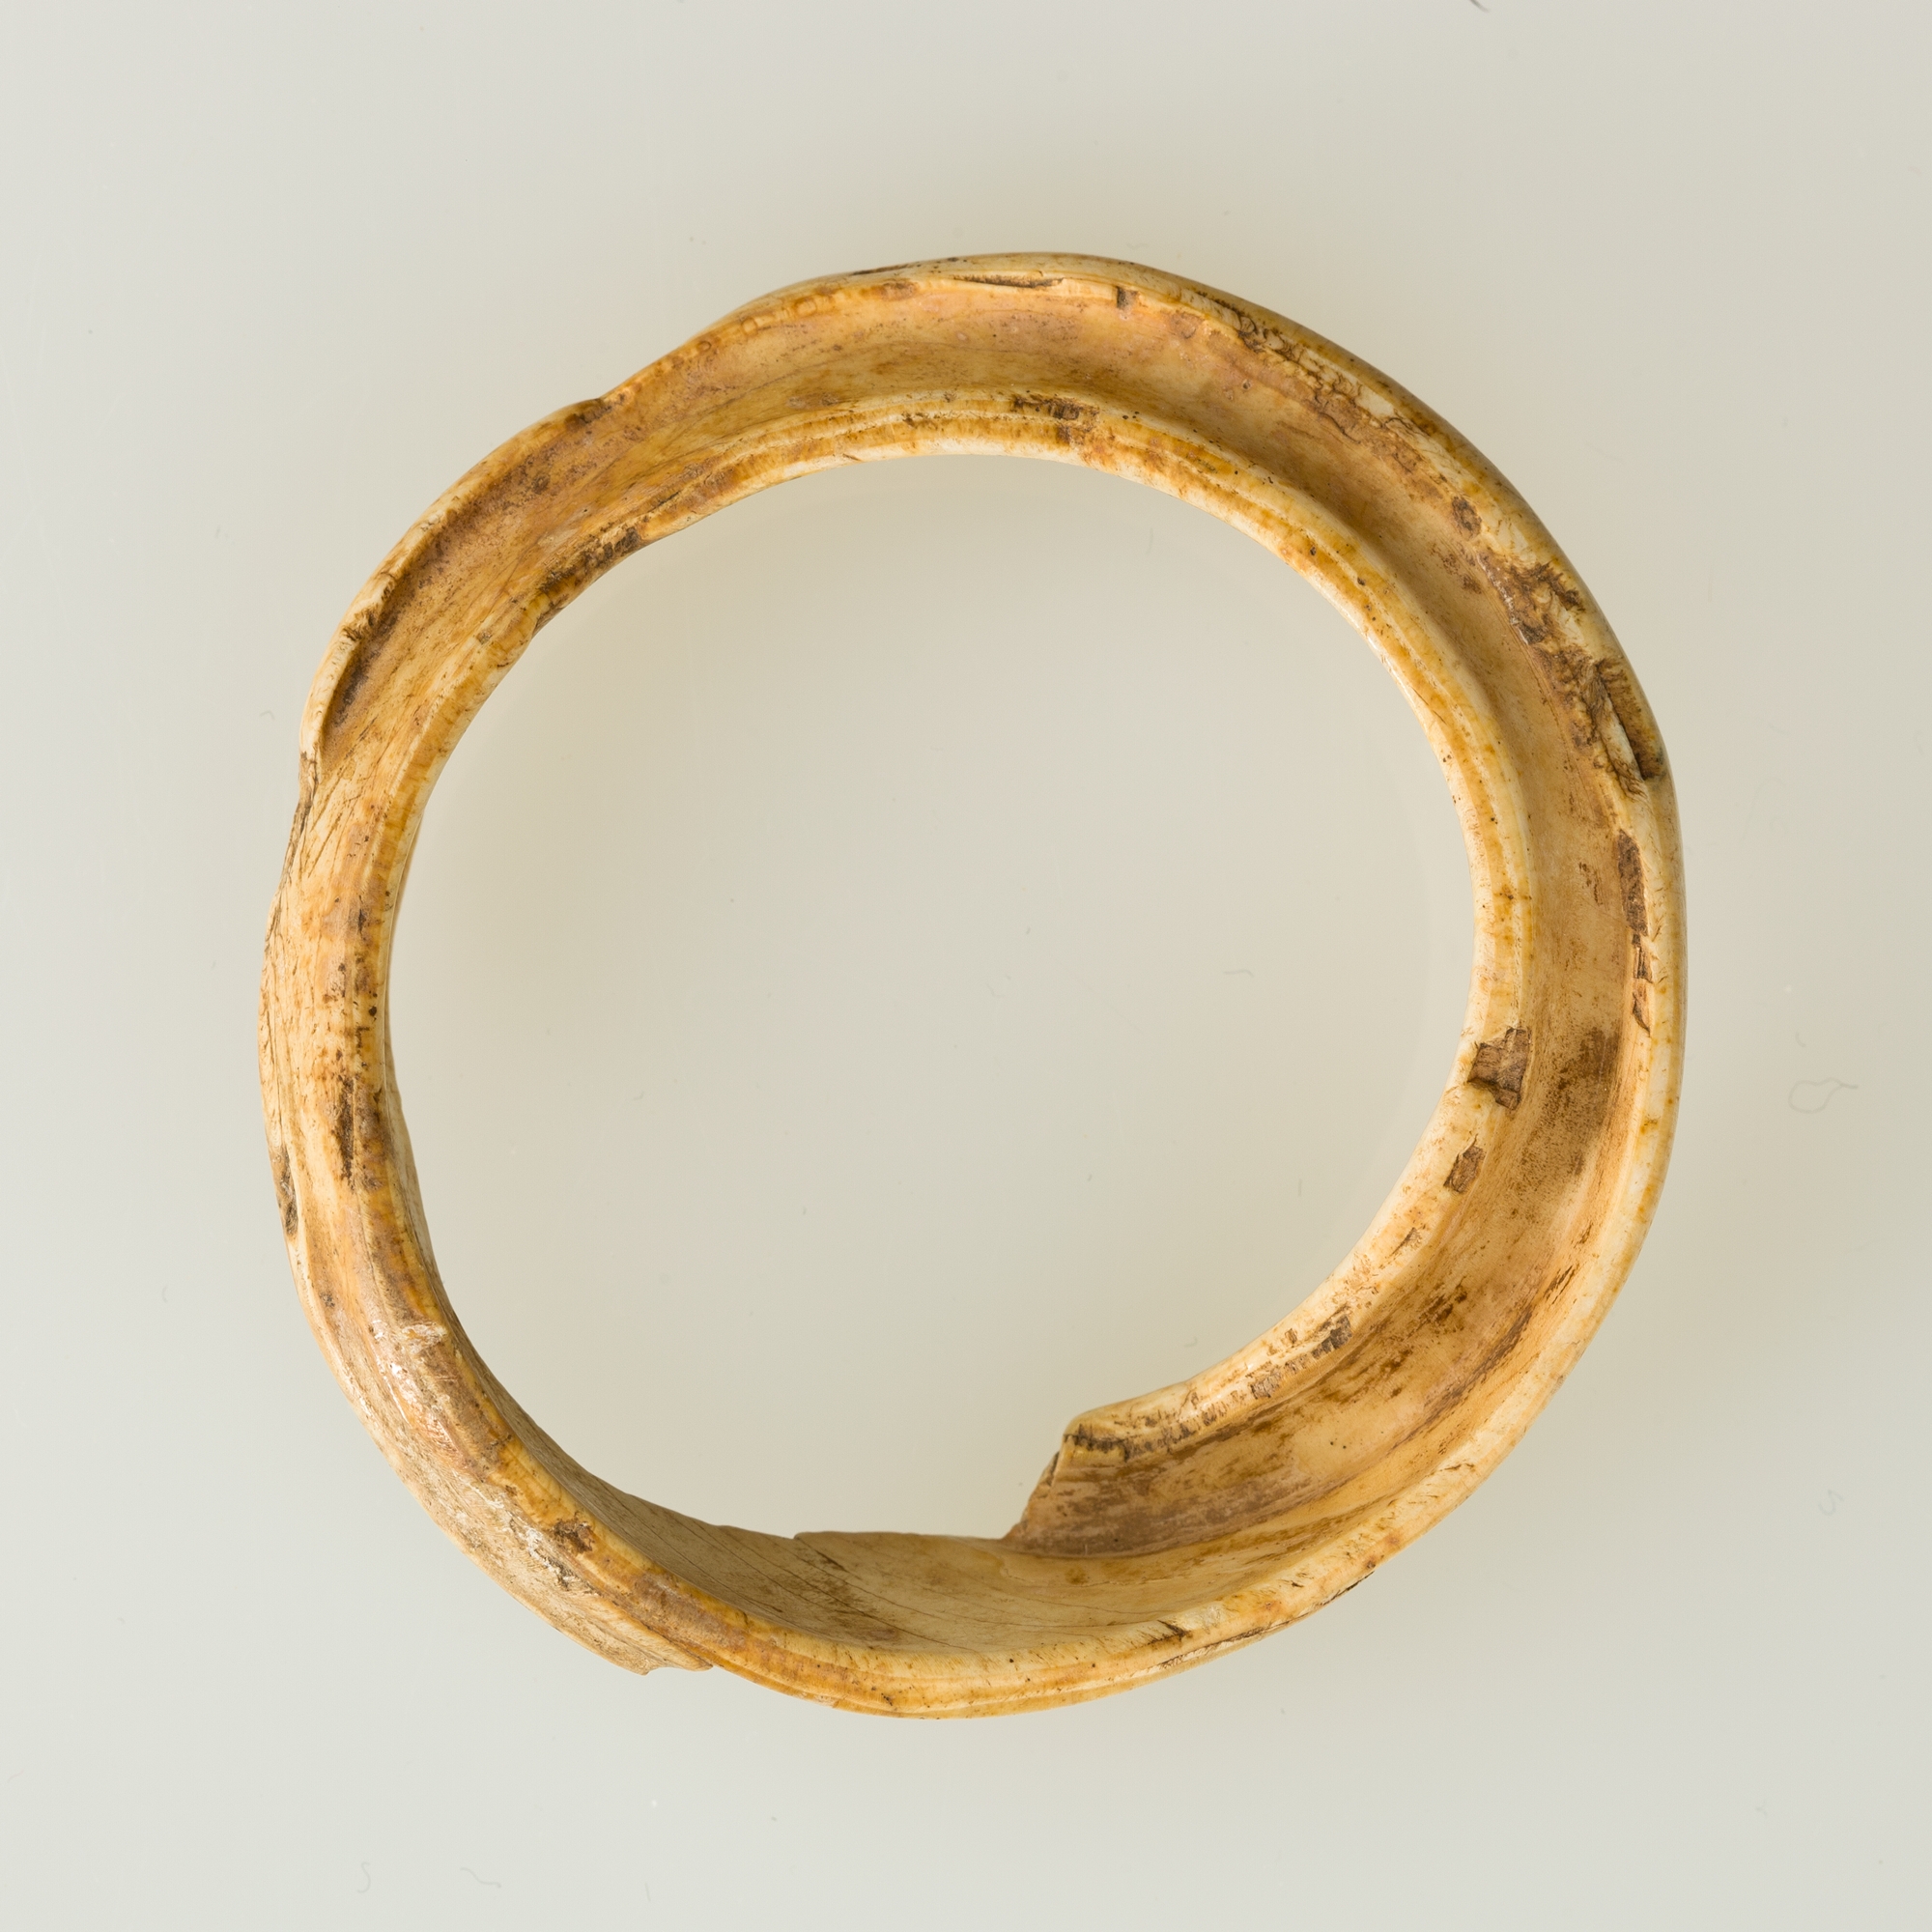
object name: bracelet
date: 3850-2960 BCE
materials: shell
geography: egypt